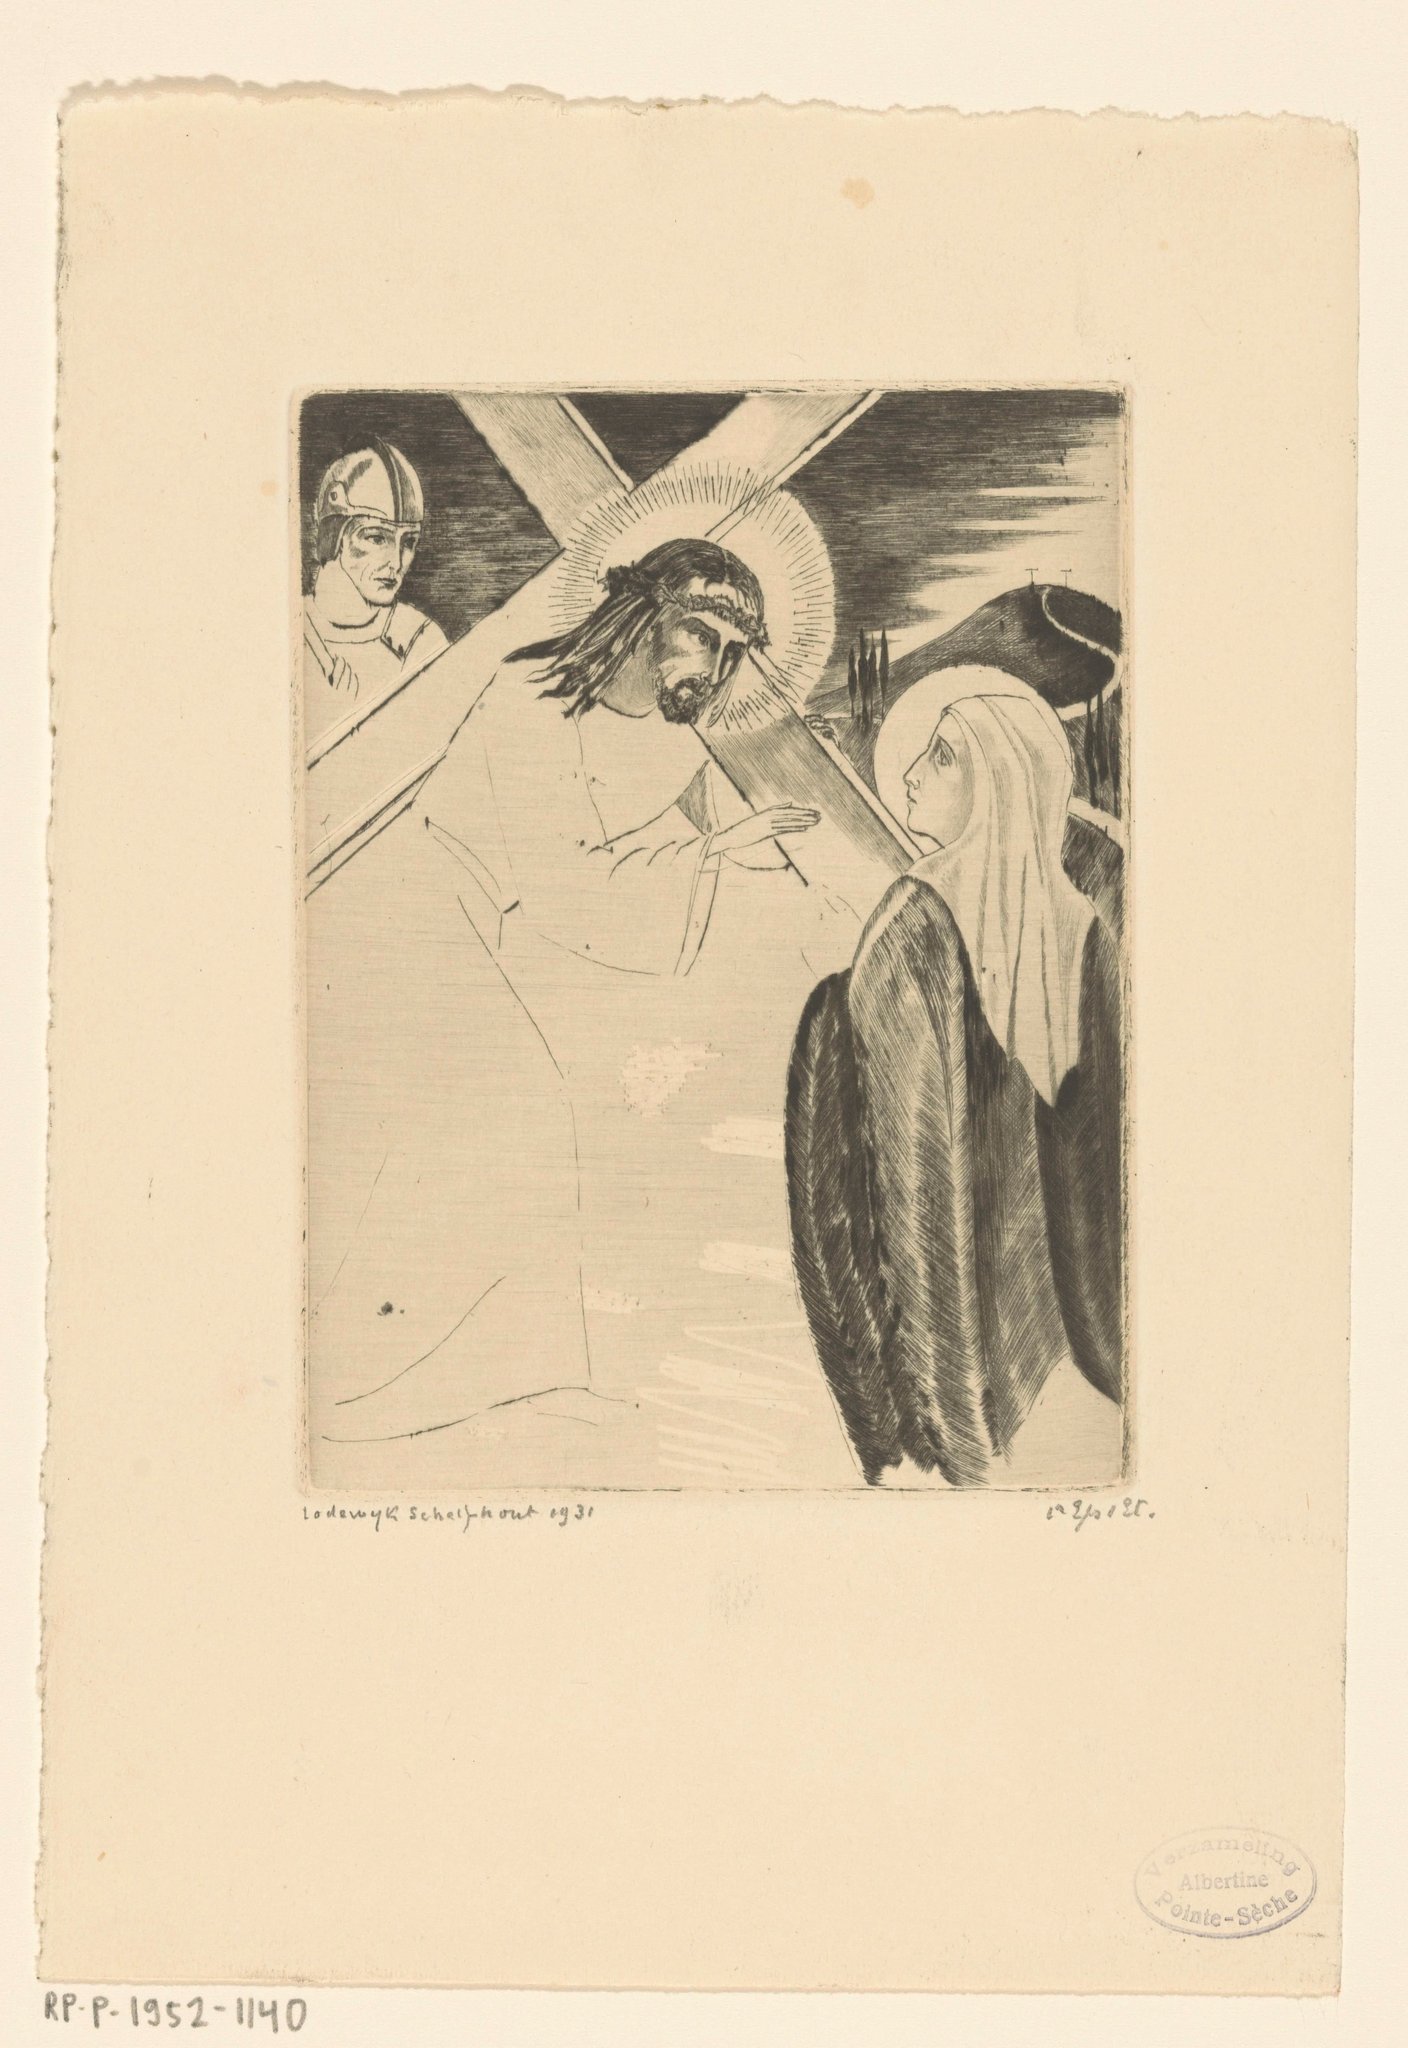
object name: print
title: Quatrième Station du Chemin de la Croix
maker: lodewijk schelfhout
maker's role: draughtsman, print maker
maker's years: 1881-1943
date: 1931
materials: paper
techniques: drypoint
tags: stations of the cross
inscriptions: collector's mark: Lugt 5i, collector's mark: Lugt 2228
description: Christus loopt langs zijn moeder Maria terwijl hij zijn kruis naar Golgota draagt, de heuvel waar hij zal worden gekruisigd.